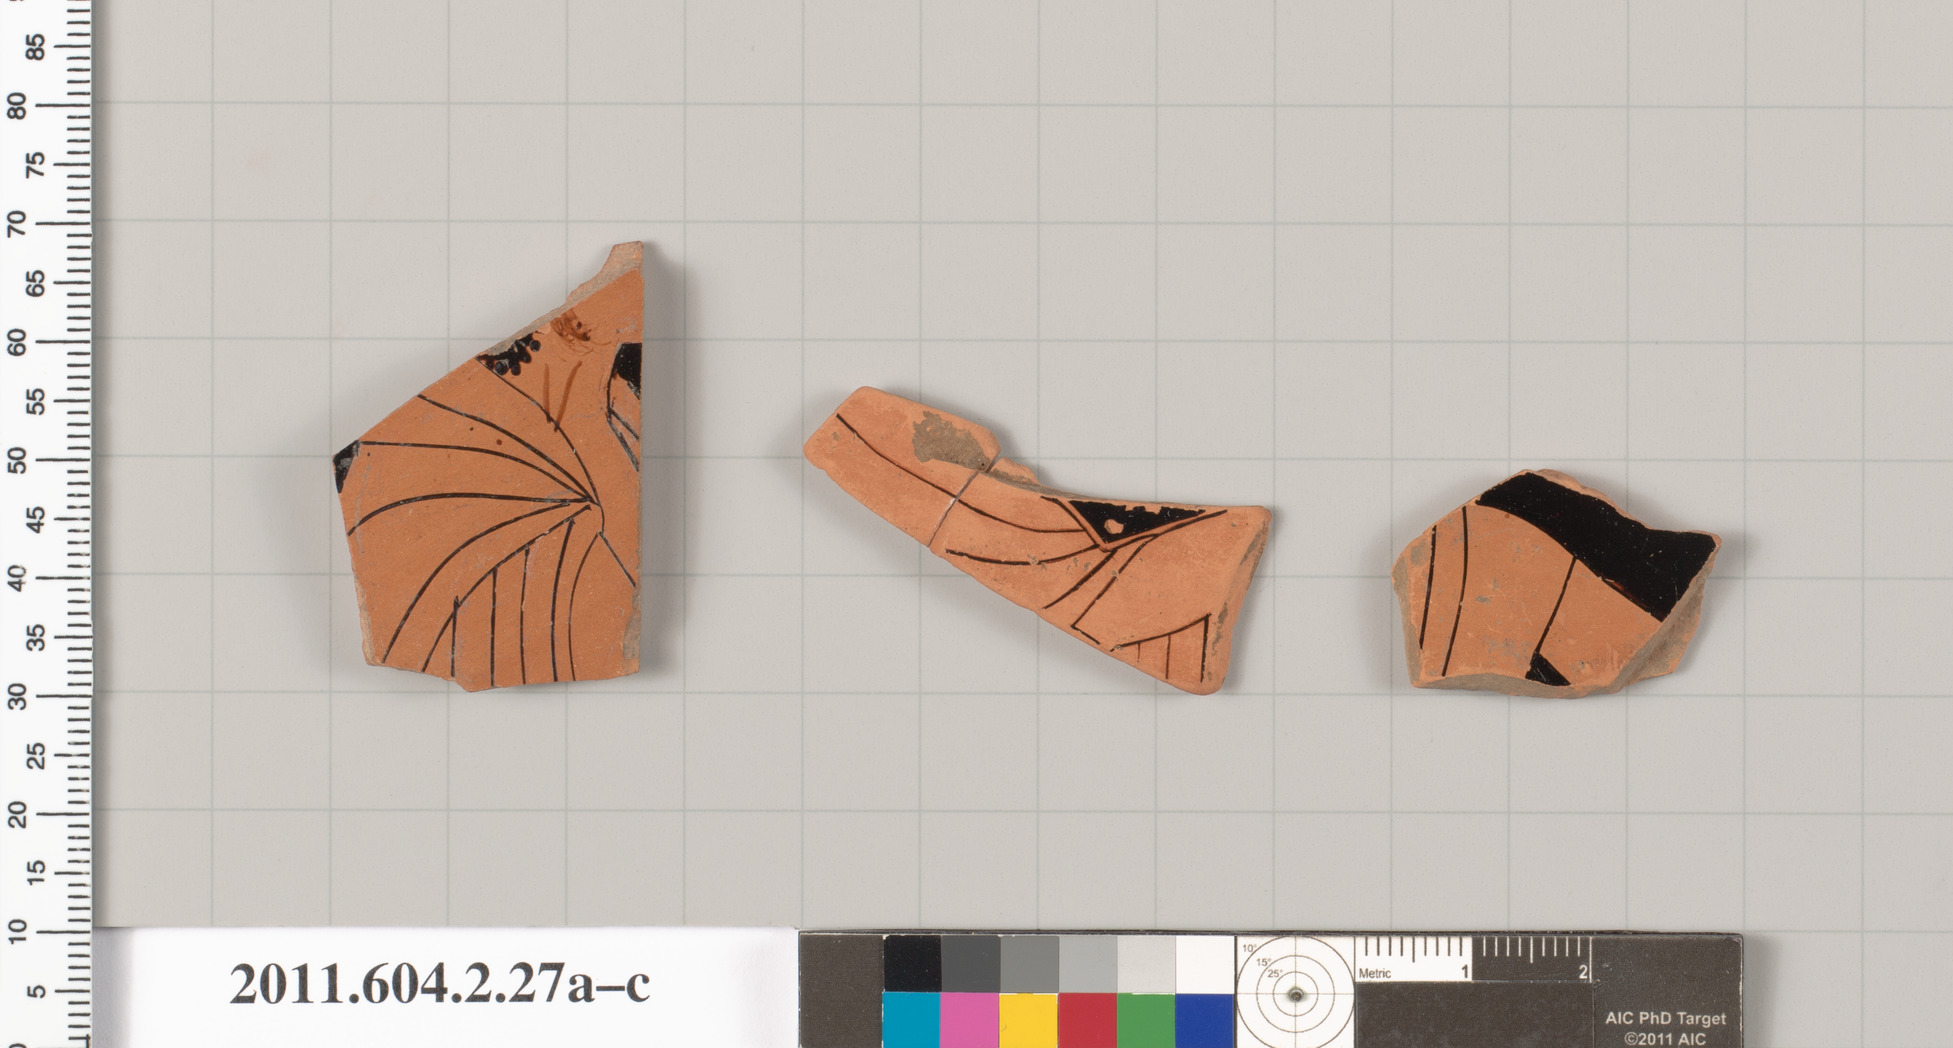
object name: psykter fragment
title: Terracotta fragments of a psykter (vase for cooling wine)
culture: greek, attic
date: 510-500 BCE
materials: terracotta